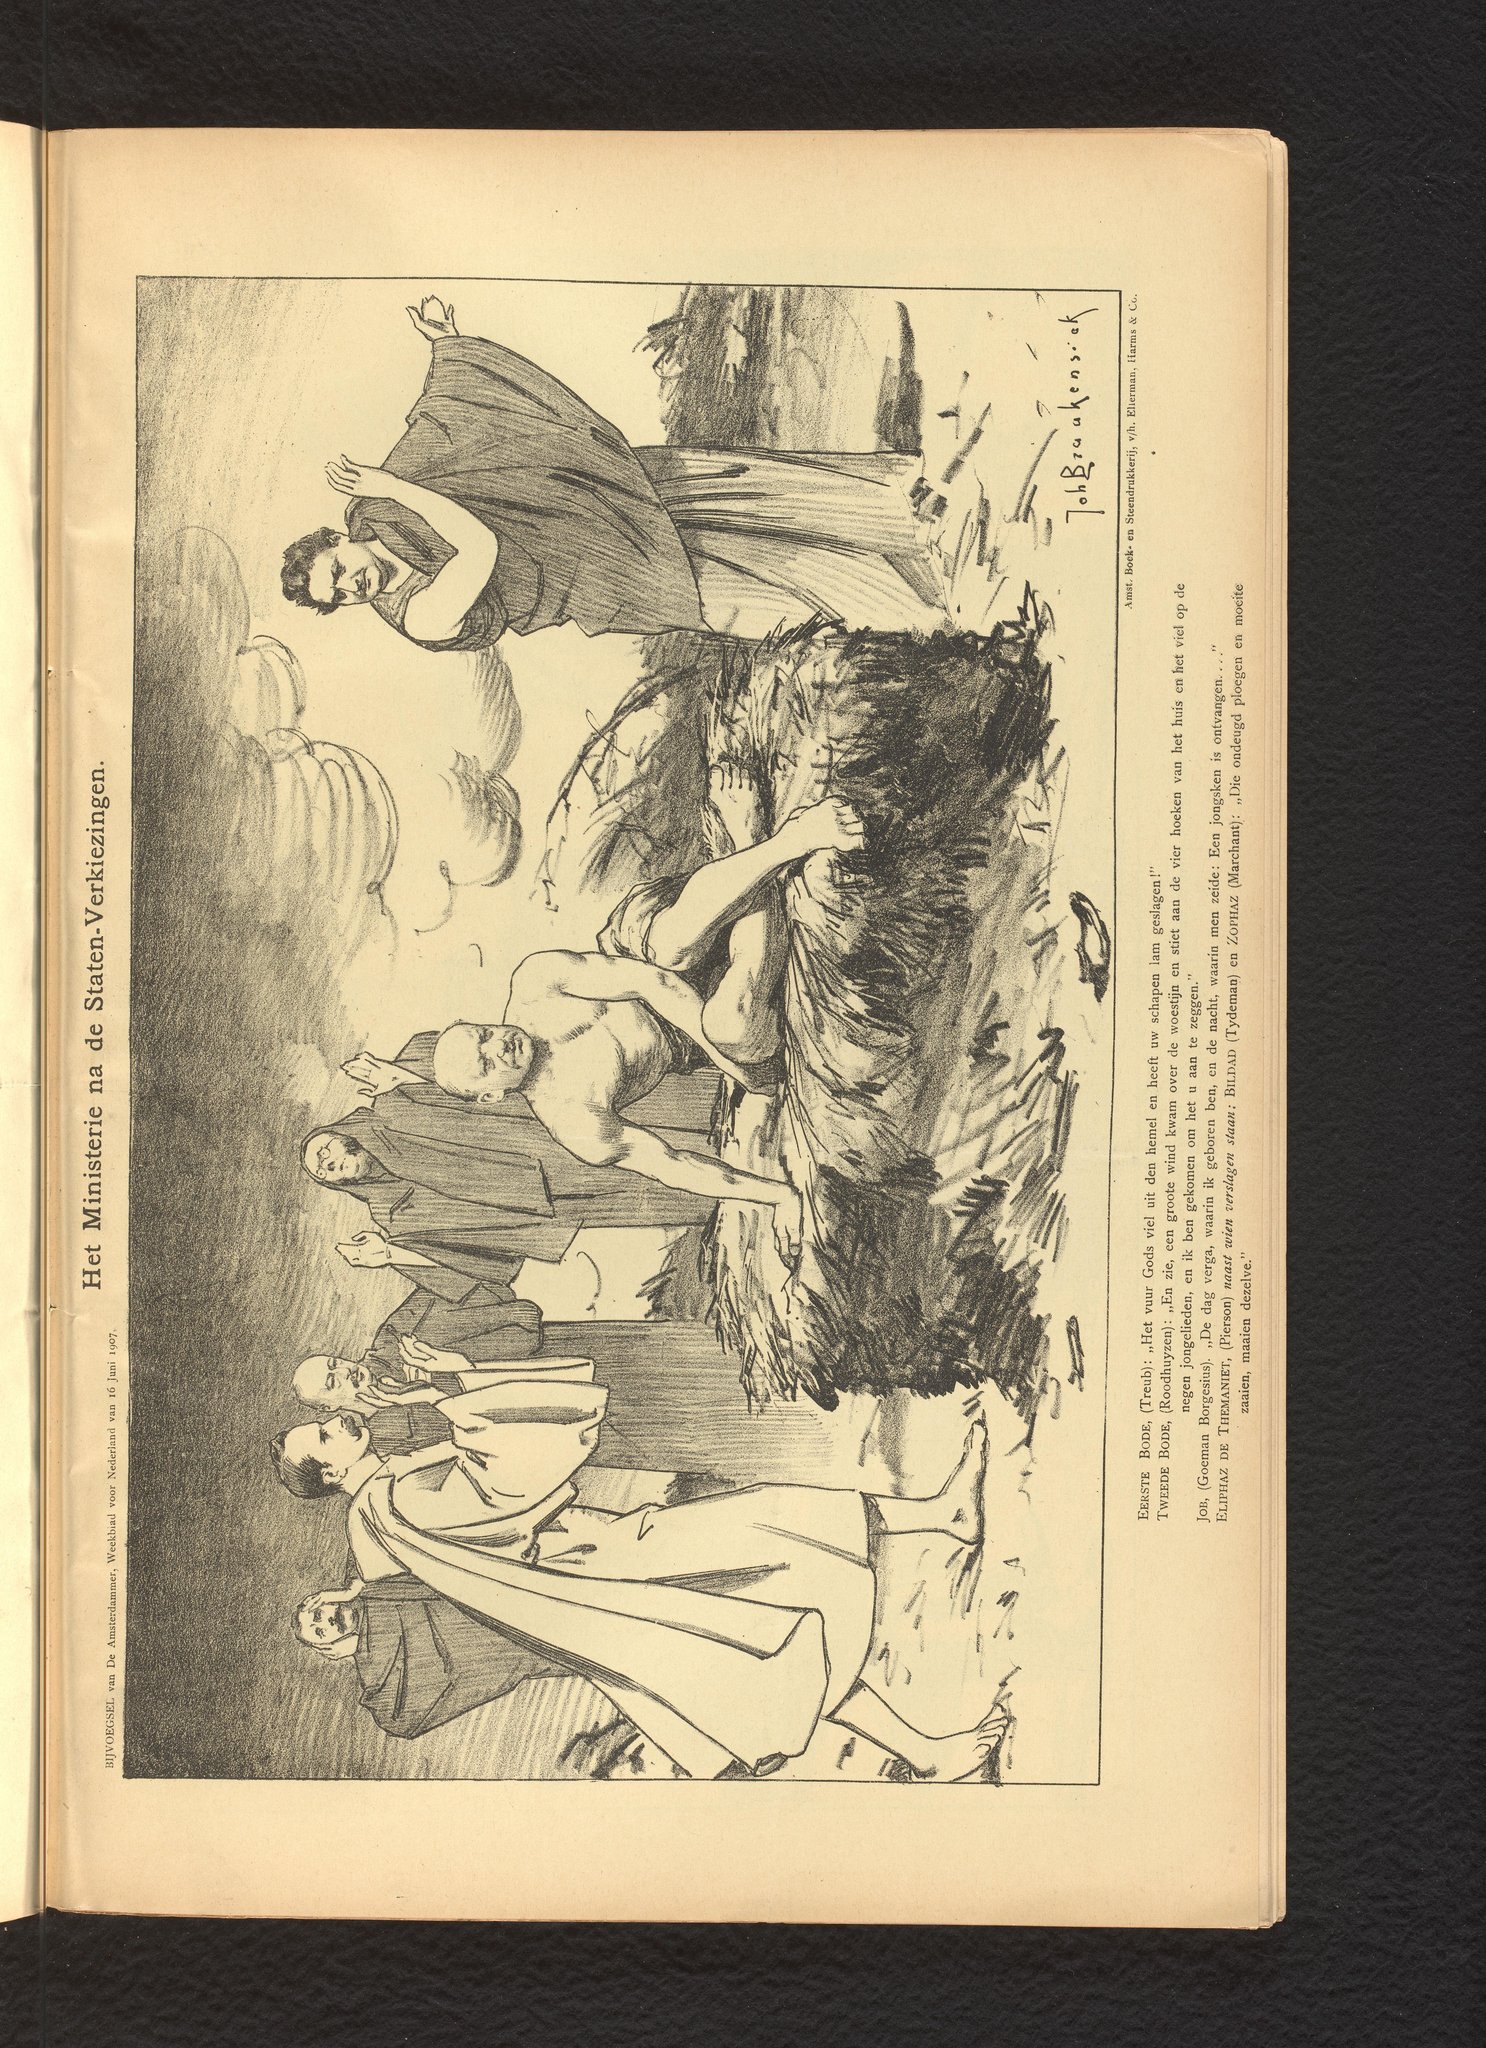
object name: cartoon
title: Het Ministerie na de Staten-Verkiezingen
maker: johan braakensiek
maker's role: draughtsman, print maker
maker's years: 1858-1940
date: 1907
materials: paper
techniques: lithograph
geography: amsterdam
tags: the hague, politician, voorschoten, job on the dunghill (job 2:7-13), when eliphaz, bildad and zophar recognize job they weep and tear their clothes in grief, political caricatures and satires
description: Hendrik Goeman Borgesius als Job op de mesthoop terwijl Treub en Roodhuyzen meer slecht nieuws brengen. Op de achtergrond de drie vrienden Elifaz, Bildad en Zofar die Job proberen te troosten.